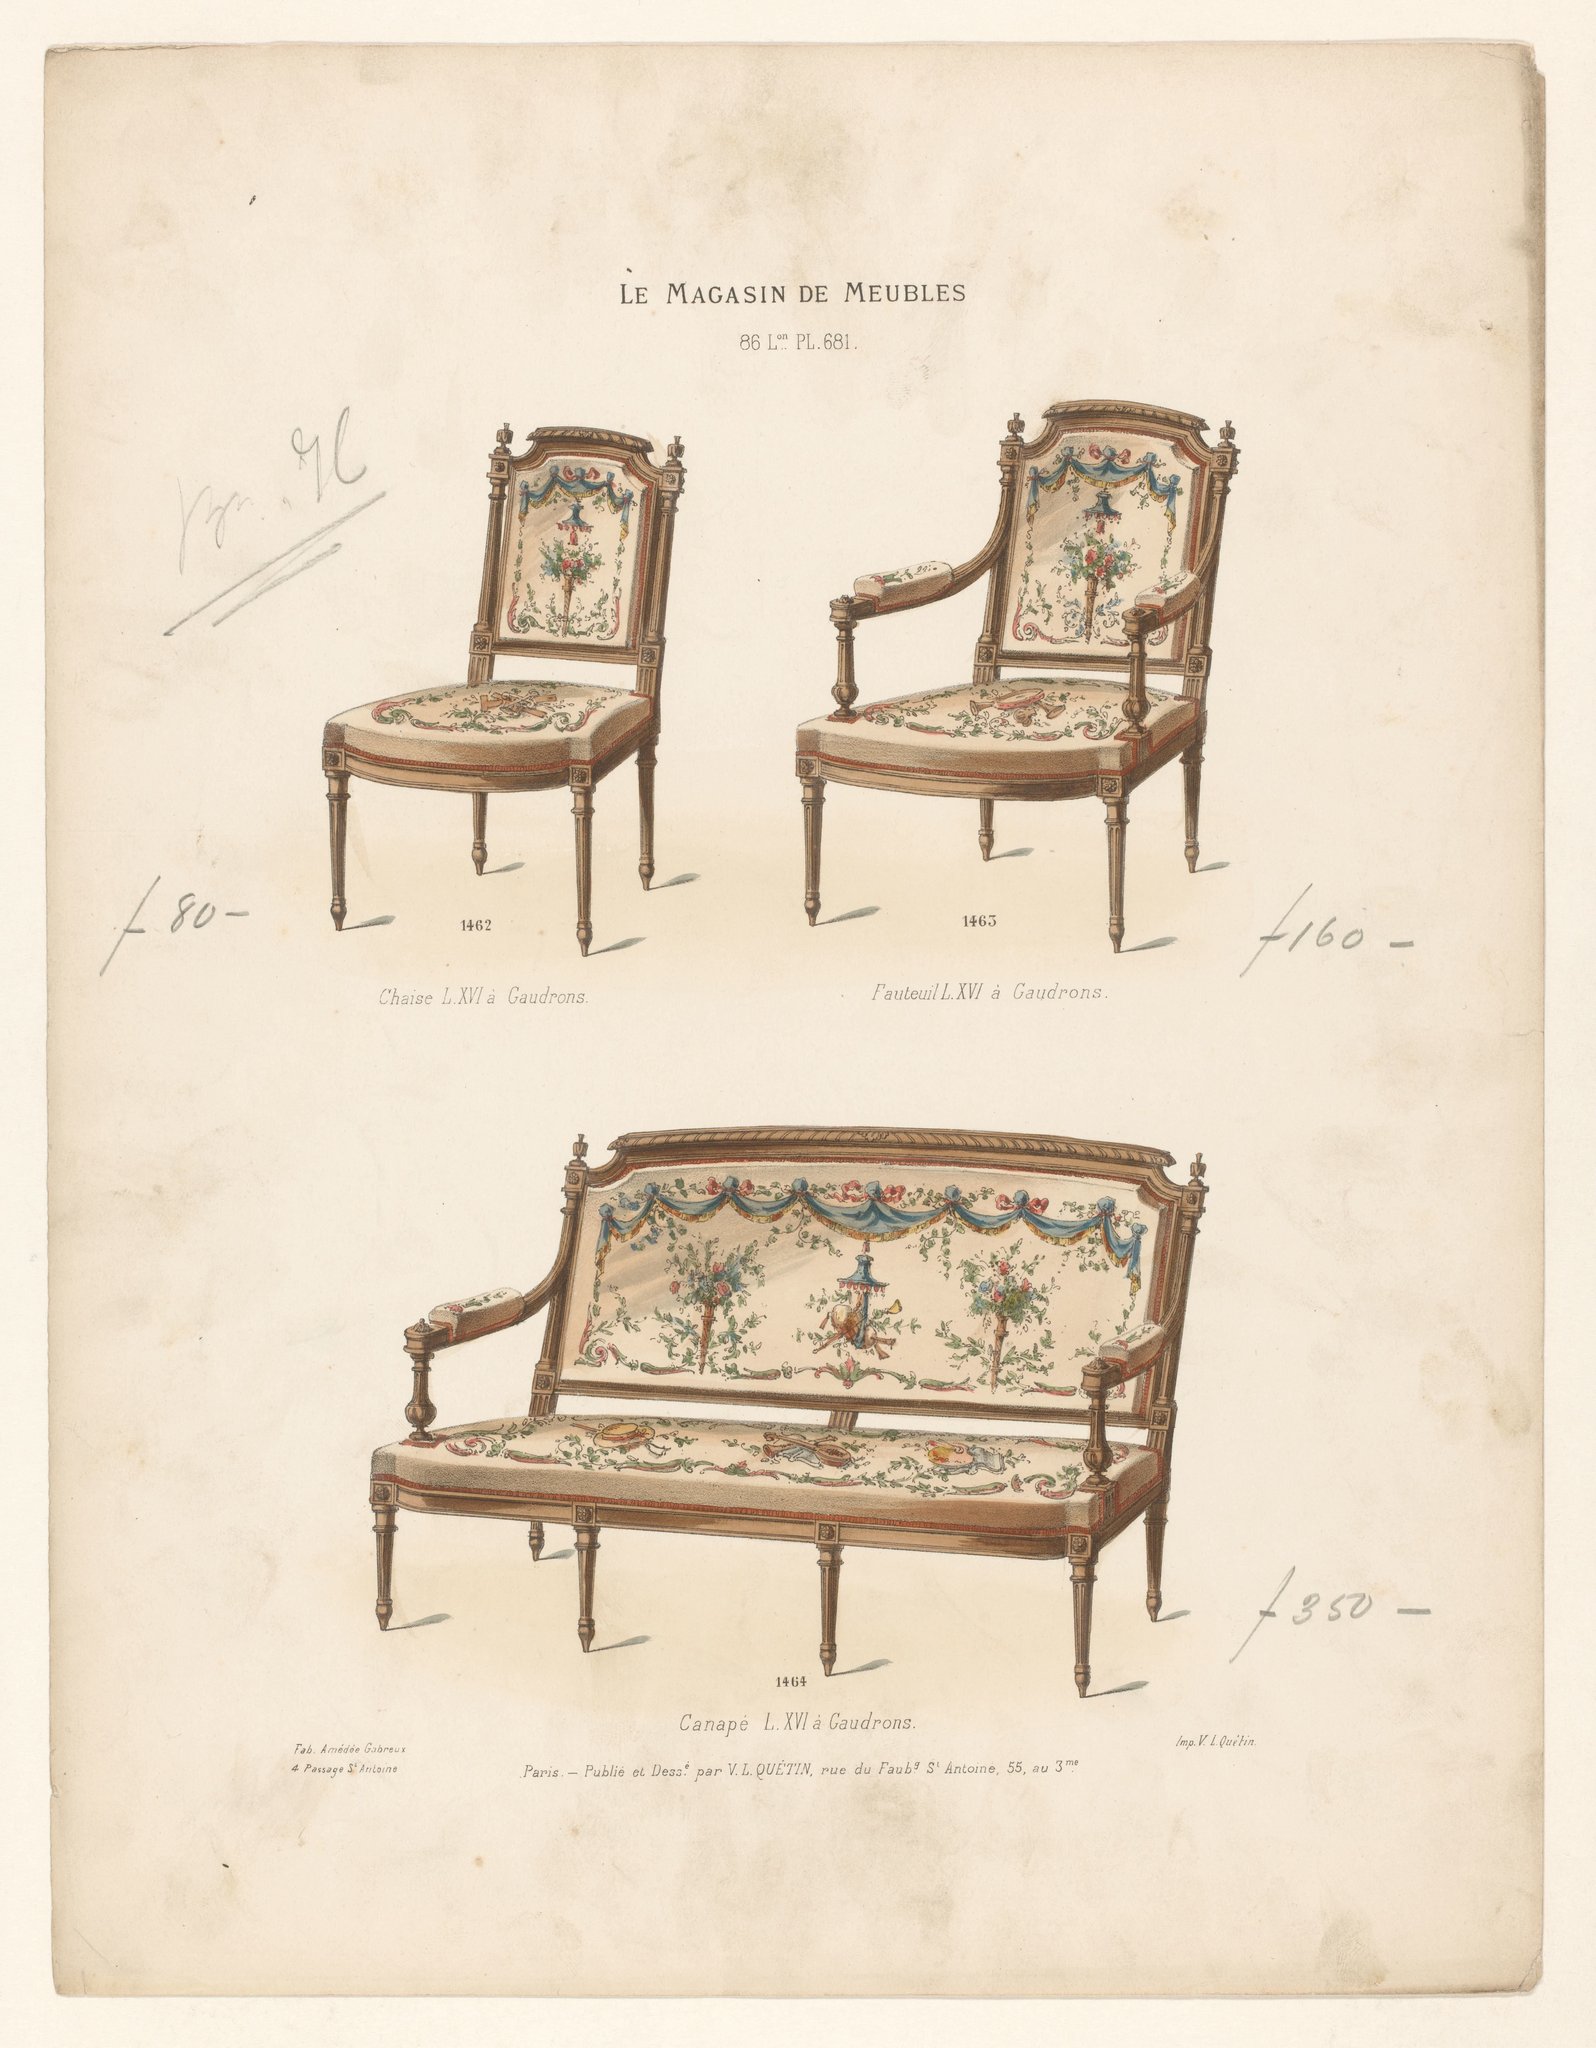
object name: print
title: Stoel, fauteuil en canapé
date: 1878-1904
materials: paper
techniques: hand coloring, lithograph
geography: paris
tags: seating furniture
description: Een stoel, fauteuil en canapé in de Lodewijk XVI-stijl. Prent uit 86e Livraison.